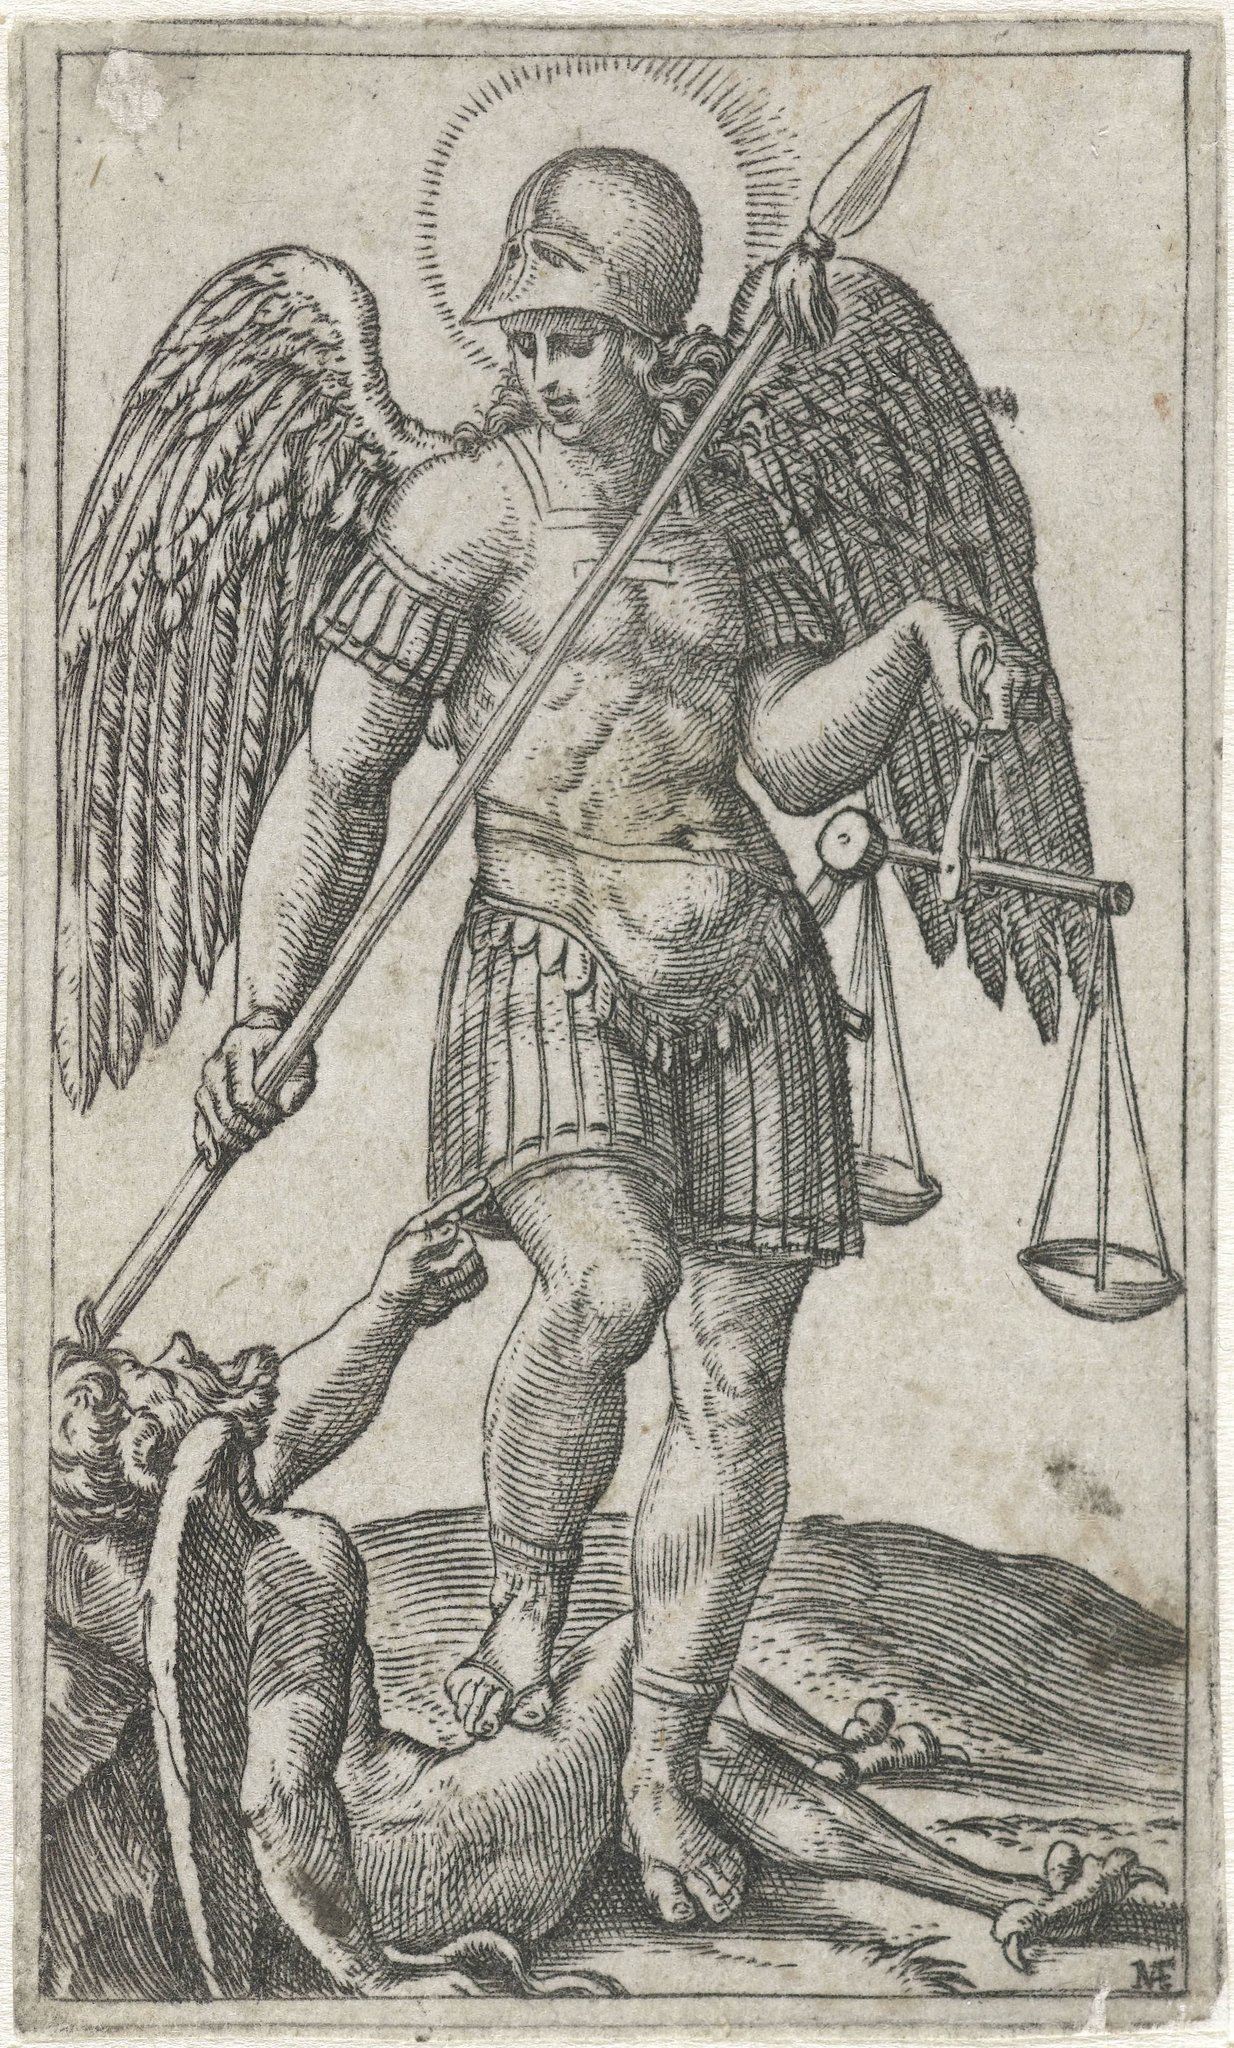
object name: print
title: Aartsengel Michaël staand op duivel met speer en weegschaal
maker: marcantonio raimondi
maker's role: print maker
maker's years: 1470-1534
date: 1500-1527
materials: paper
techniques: engraving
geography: italy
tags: the archangel michael fighting the dragon (devil, satan)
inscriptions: collector's mark: Lugt 240